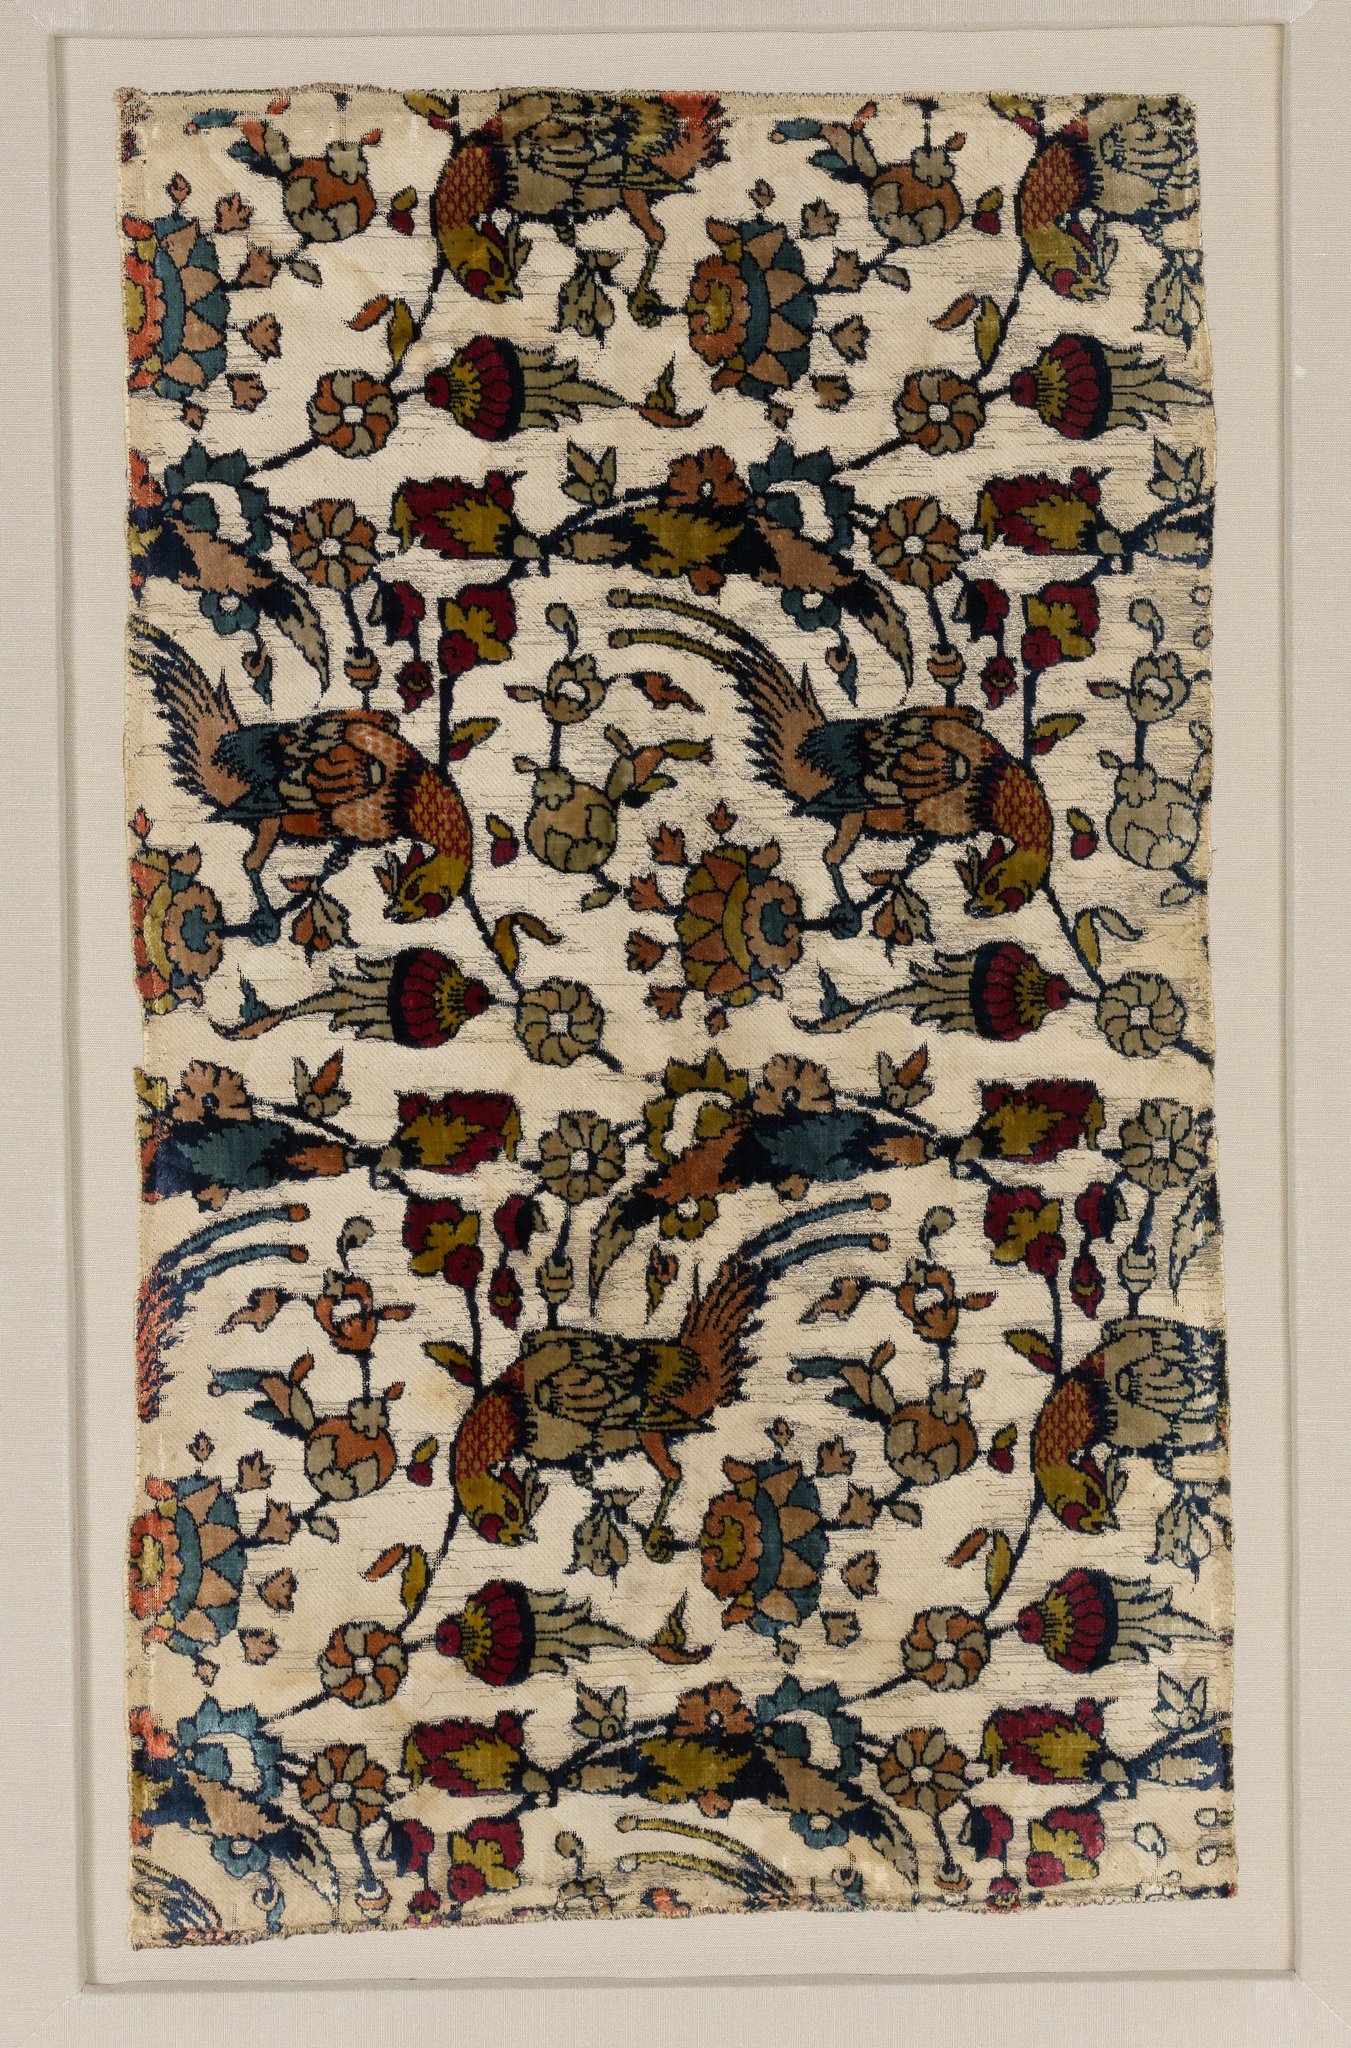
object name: textile fragment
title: Velvet Fragment with Bird and Flower Design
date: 1551-1600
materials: metal thread, silk, velvet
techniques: cutting, voiding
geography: iran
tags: birds,flowers